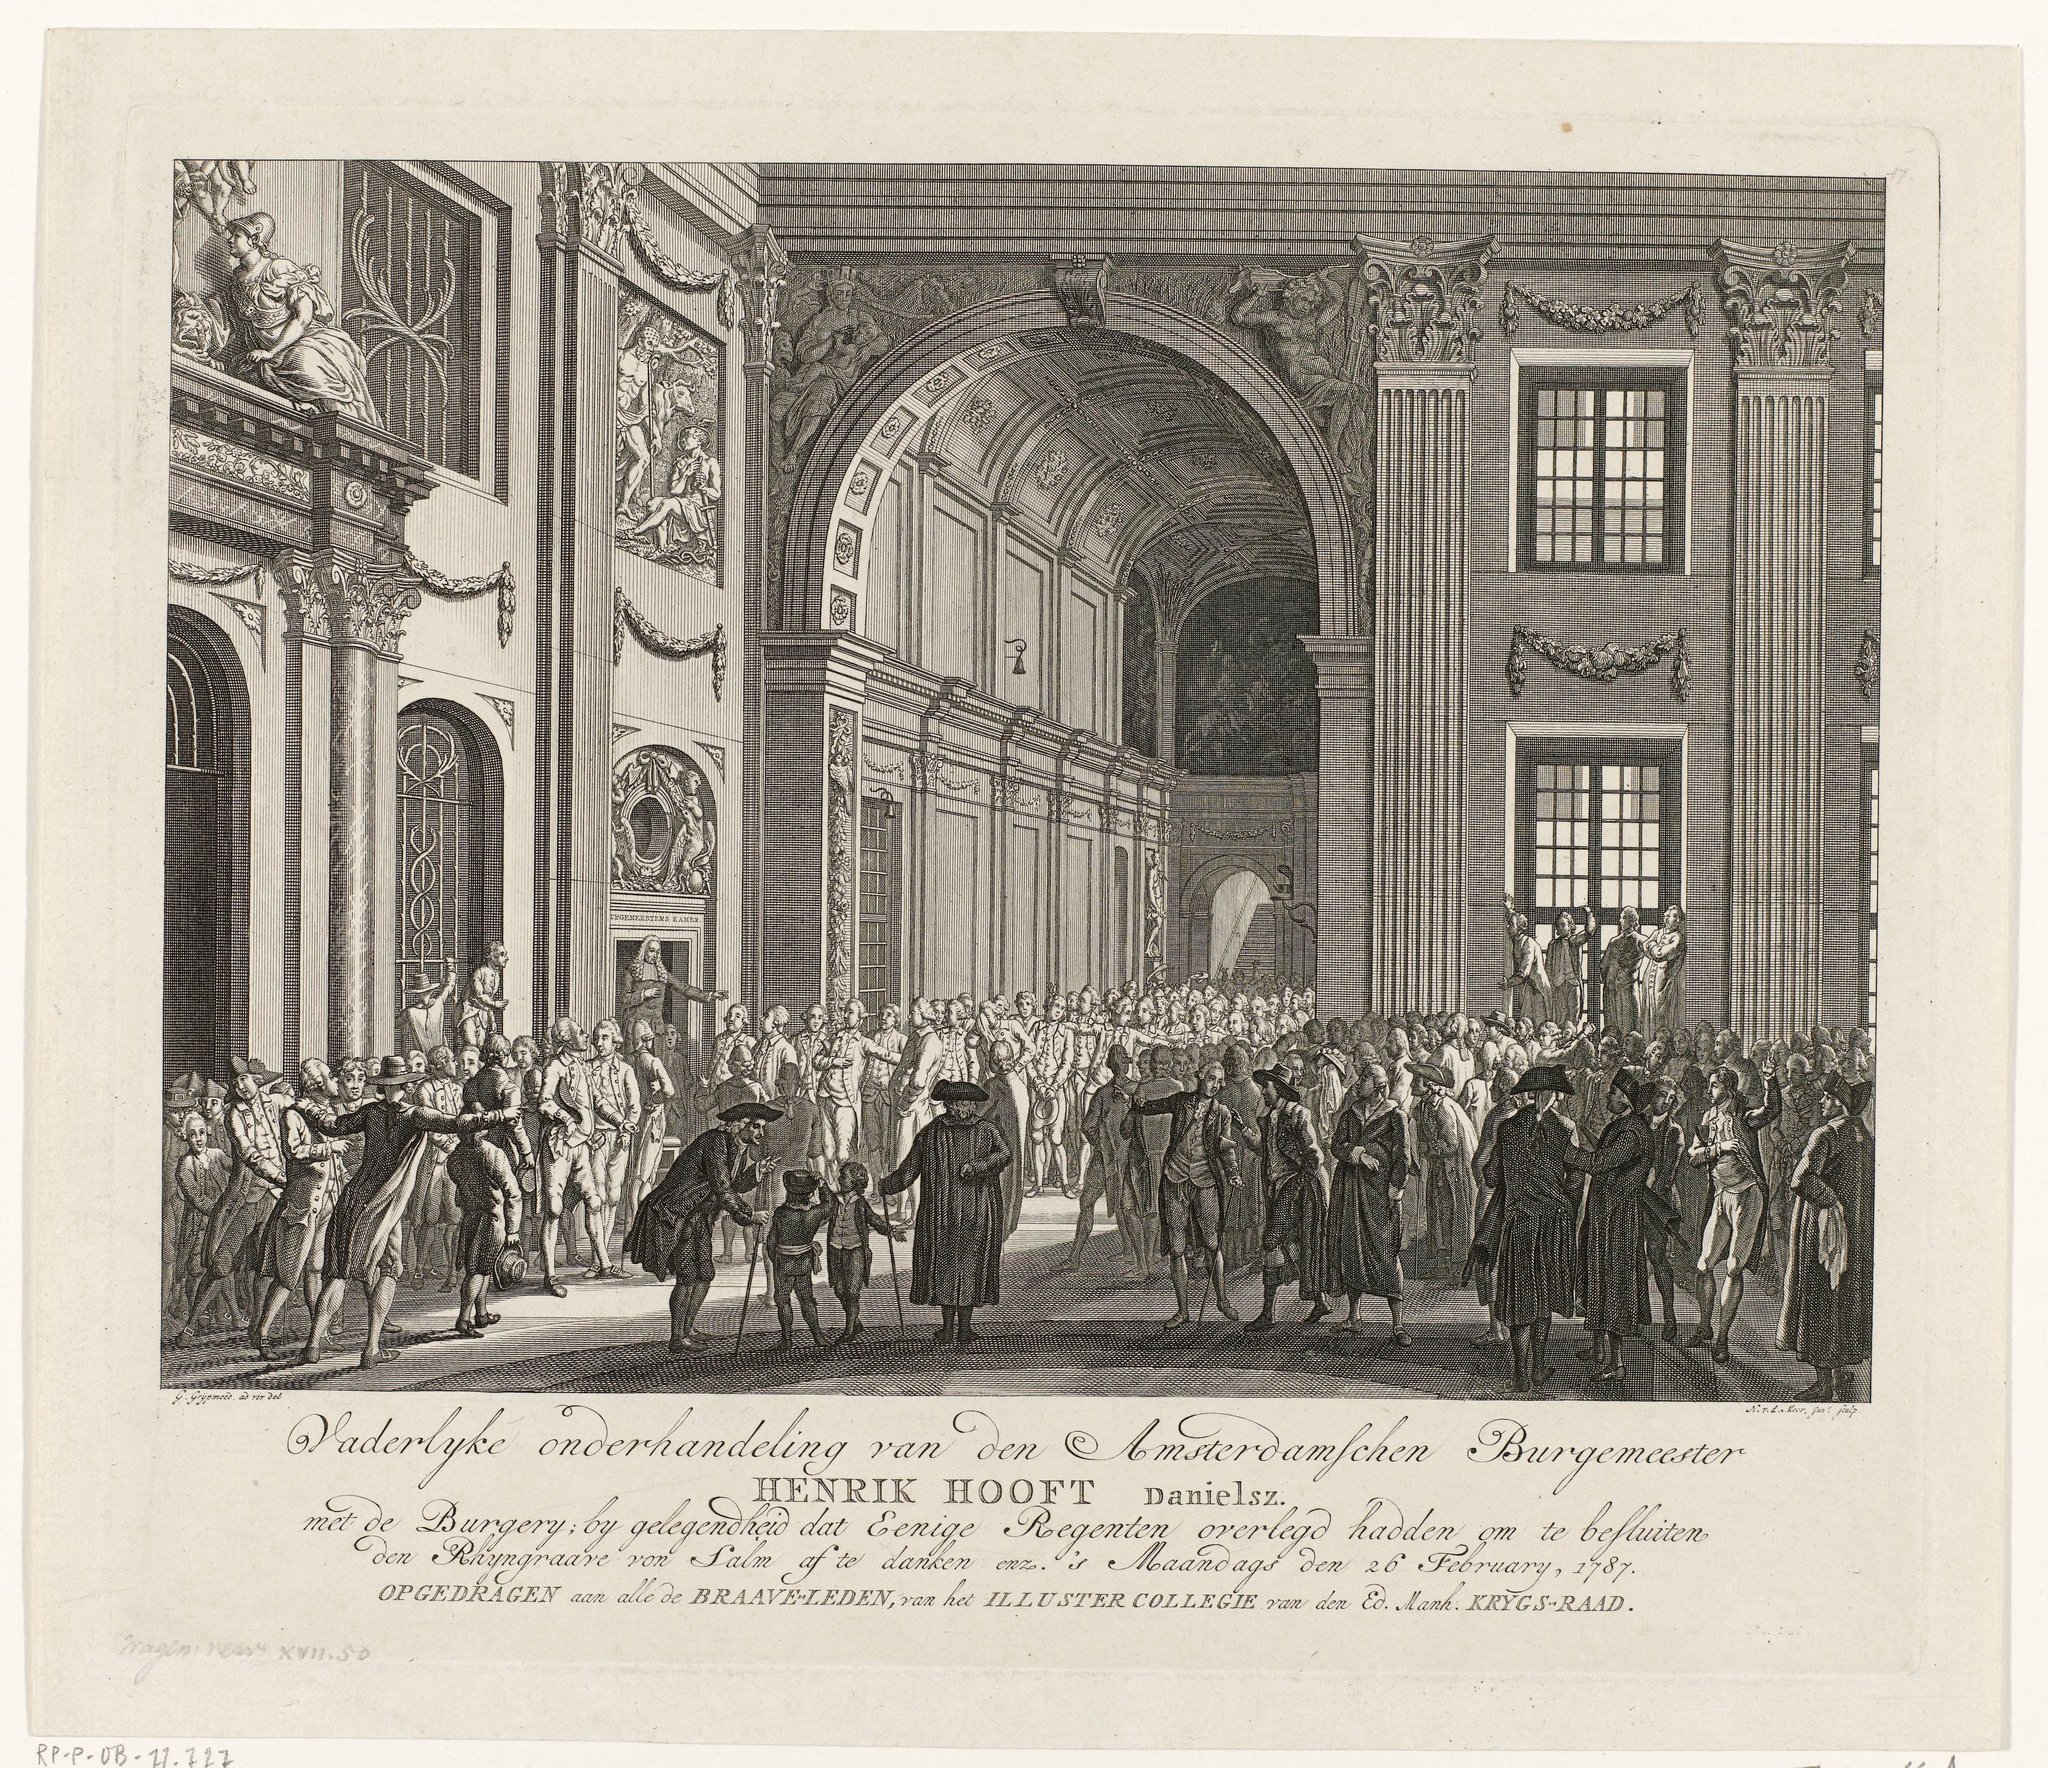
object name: print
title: Vaderlyke onderhandeling van den Amsterdamschen Burgemeester Henrik Hooft Danielsz. met de Burgery; by gelegenheid dat Eenige Regenten (...) 1787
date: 1787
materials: paper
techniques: engraving, etching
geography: amsterdam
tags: amsterdam, mayor, hendrik danielsz. hooft, rijngraaf van salm frederik iii, crowd, mob, mayor, burgomaster, person addressing a group, orator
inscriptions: collector's mark: Lugt 2228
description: De Amsterdamse burgemeester Hendrik Danielsz. Hooft onderhandelt met de burgerij over het afdanken van de Rijngraaf van Salm, 26 februari 1787. Hooft spreekt staande voor de ingang van de burgemeesterskamer in het Stadhuis de samengestroomde burgers toe.